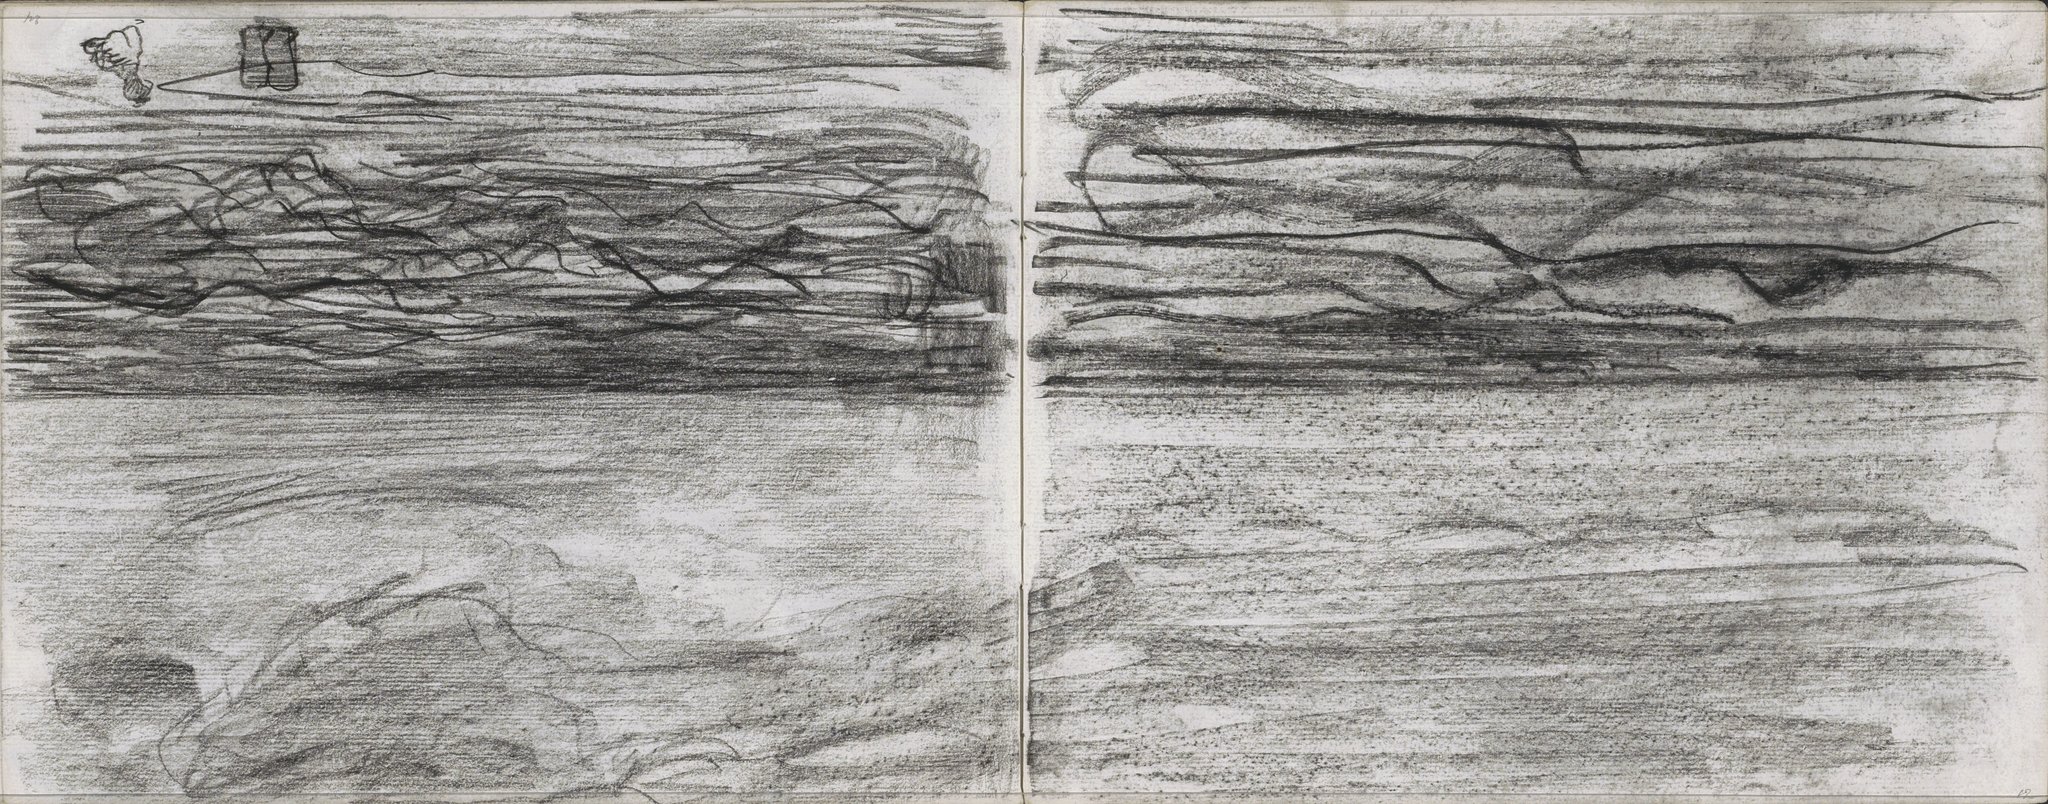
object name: sketchbook leaf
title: Zeegezicht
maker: isaac israels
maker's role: draughtsman, painter, print maker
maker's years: 1865-1934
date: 1875-1934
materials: chalk, paper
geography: the hague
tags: sea (seascape)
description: Blad 11 verso en blad 12 recto uit schetsboek XIV met 17 bladen.